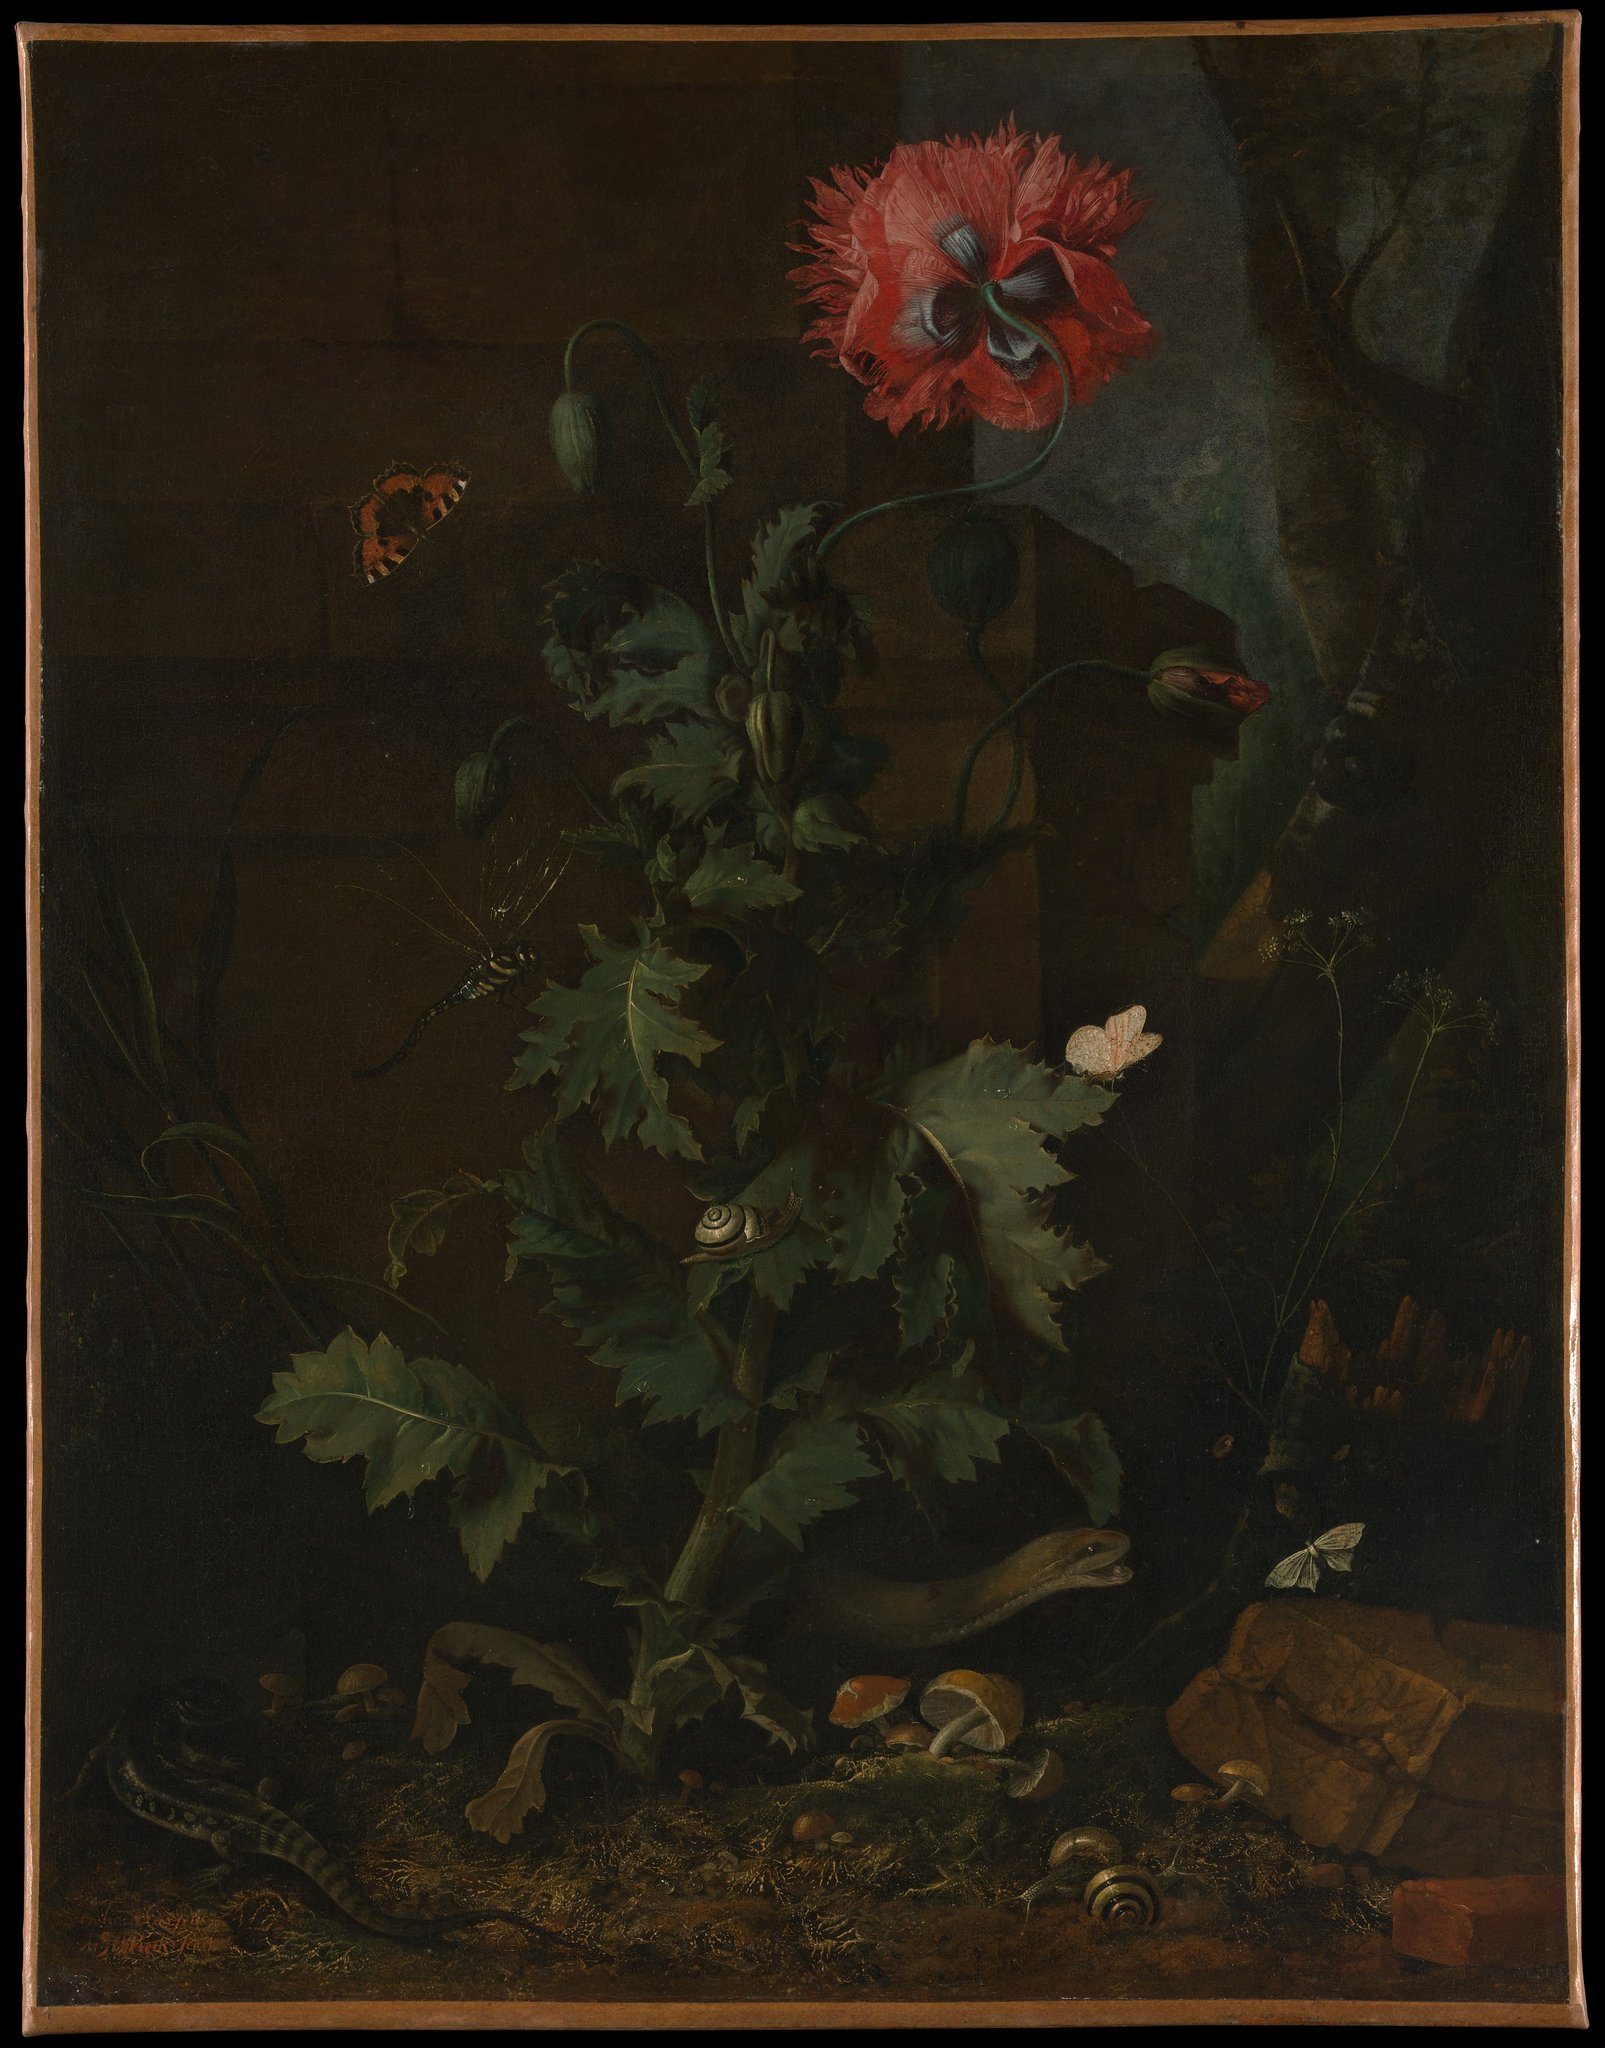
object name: painting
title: Still Life with Poppy, Insects, and Reptiles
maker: otto marseus van schrieck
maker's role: artist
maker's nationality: dutch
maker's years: 1619-1678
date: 1670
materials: canvas, oil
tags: insects,snails,lizards,snakes,poppies,still life